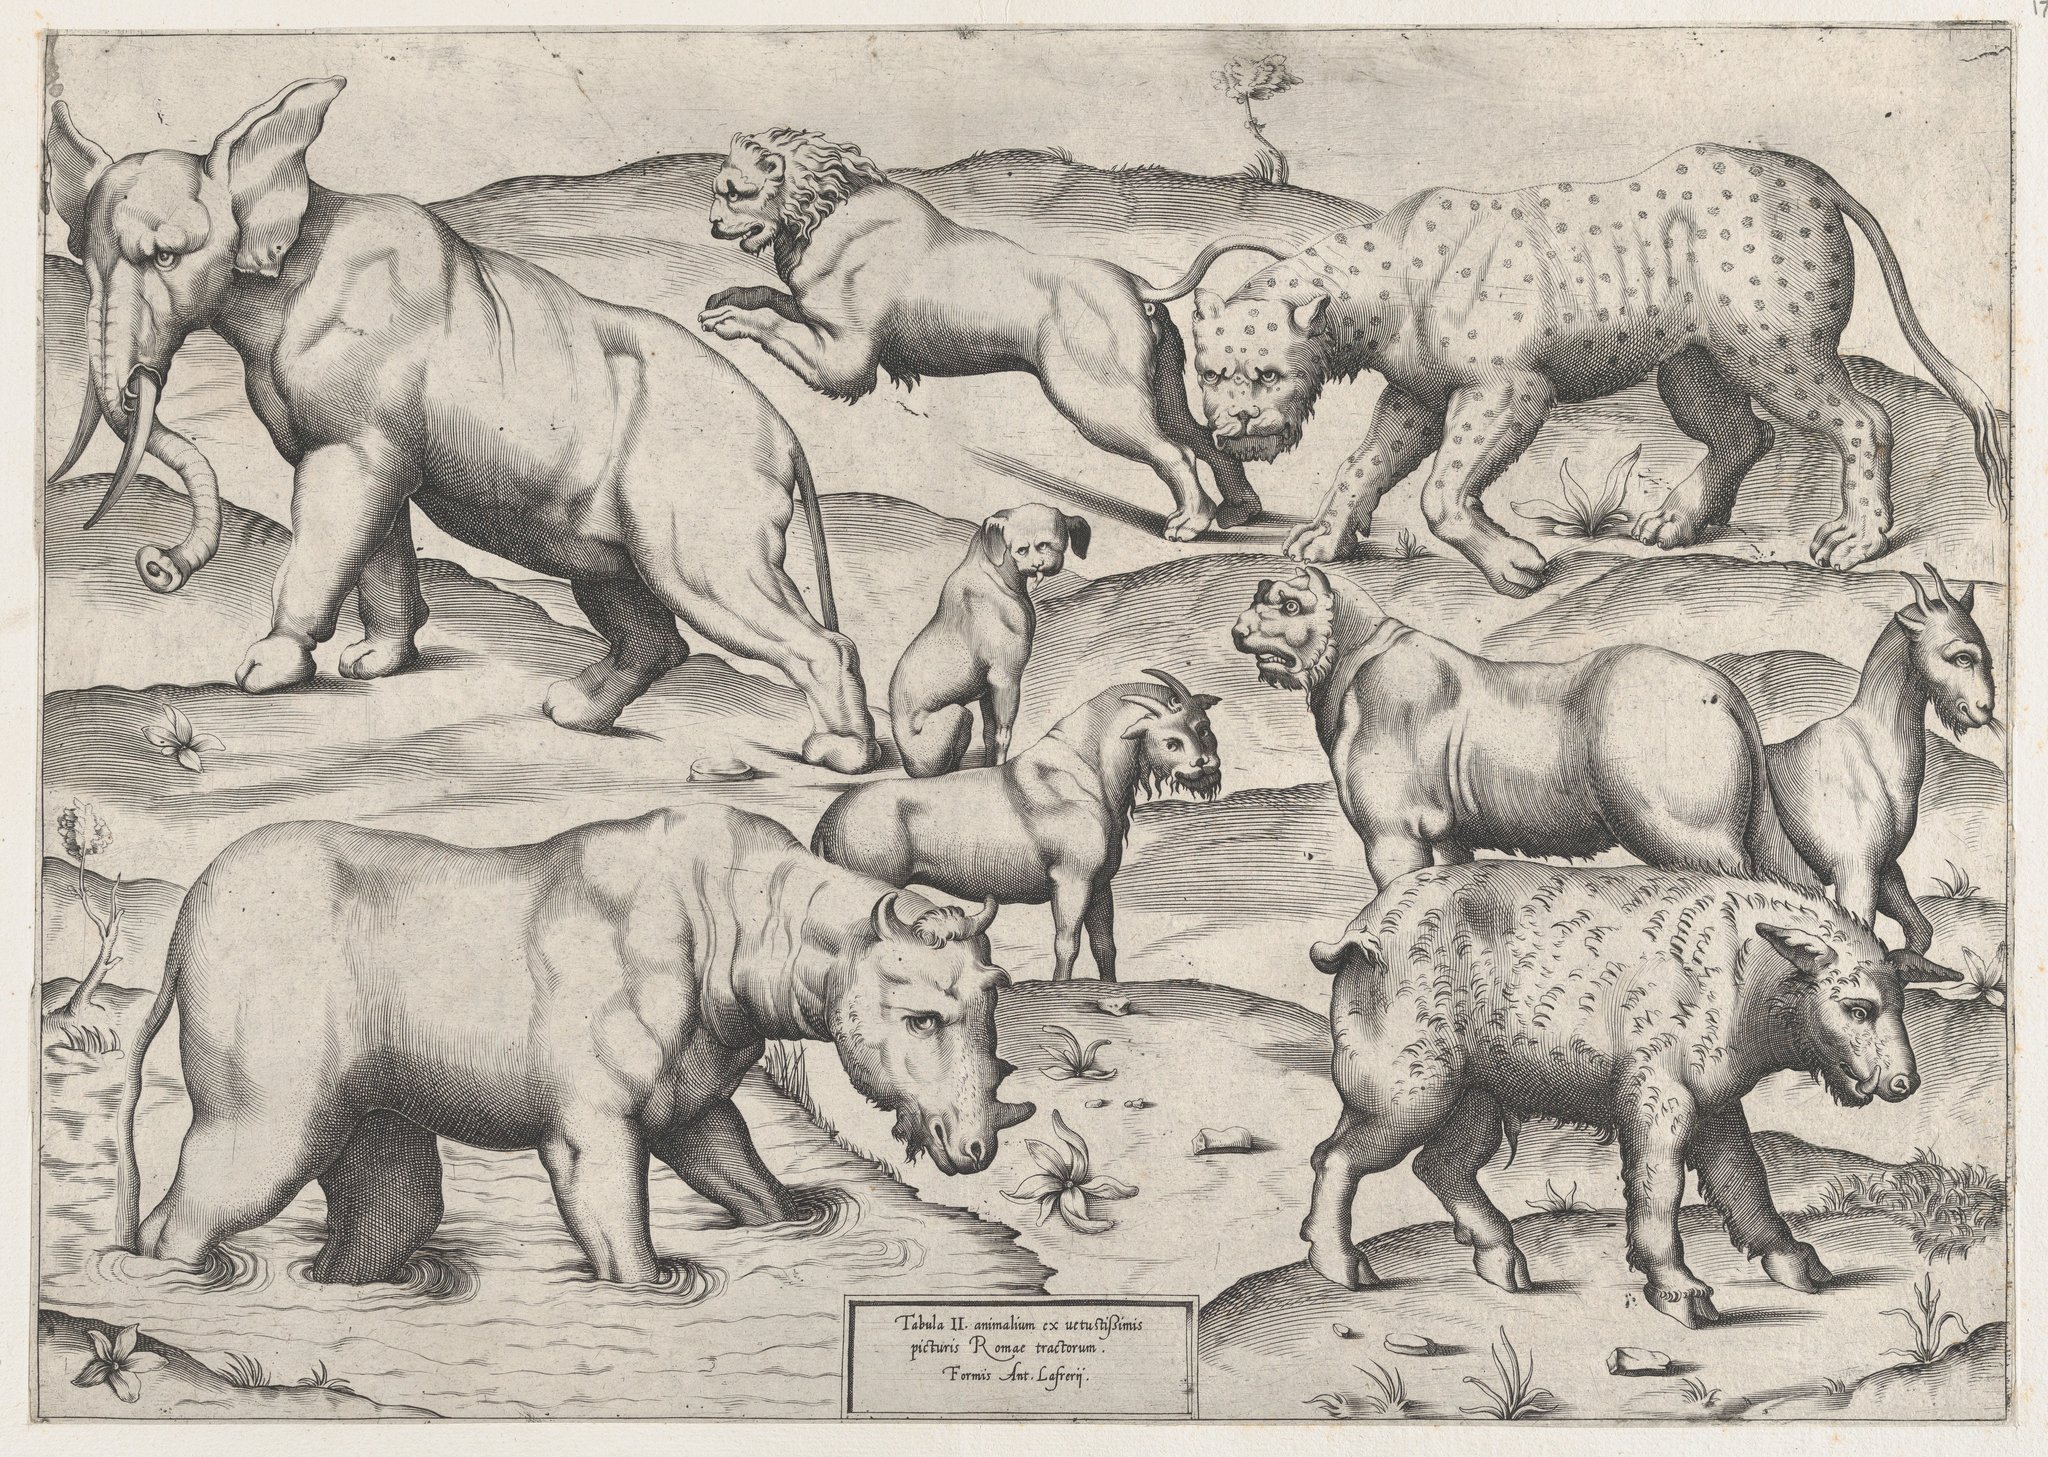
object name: print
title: Wild Animals, from antique wall paintings, plate 2, from "Speculum Romanae Magnificentiae"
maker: Anonymous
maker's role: artist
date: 1547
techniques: engraving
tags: animals